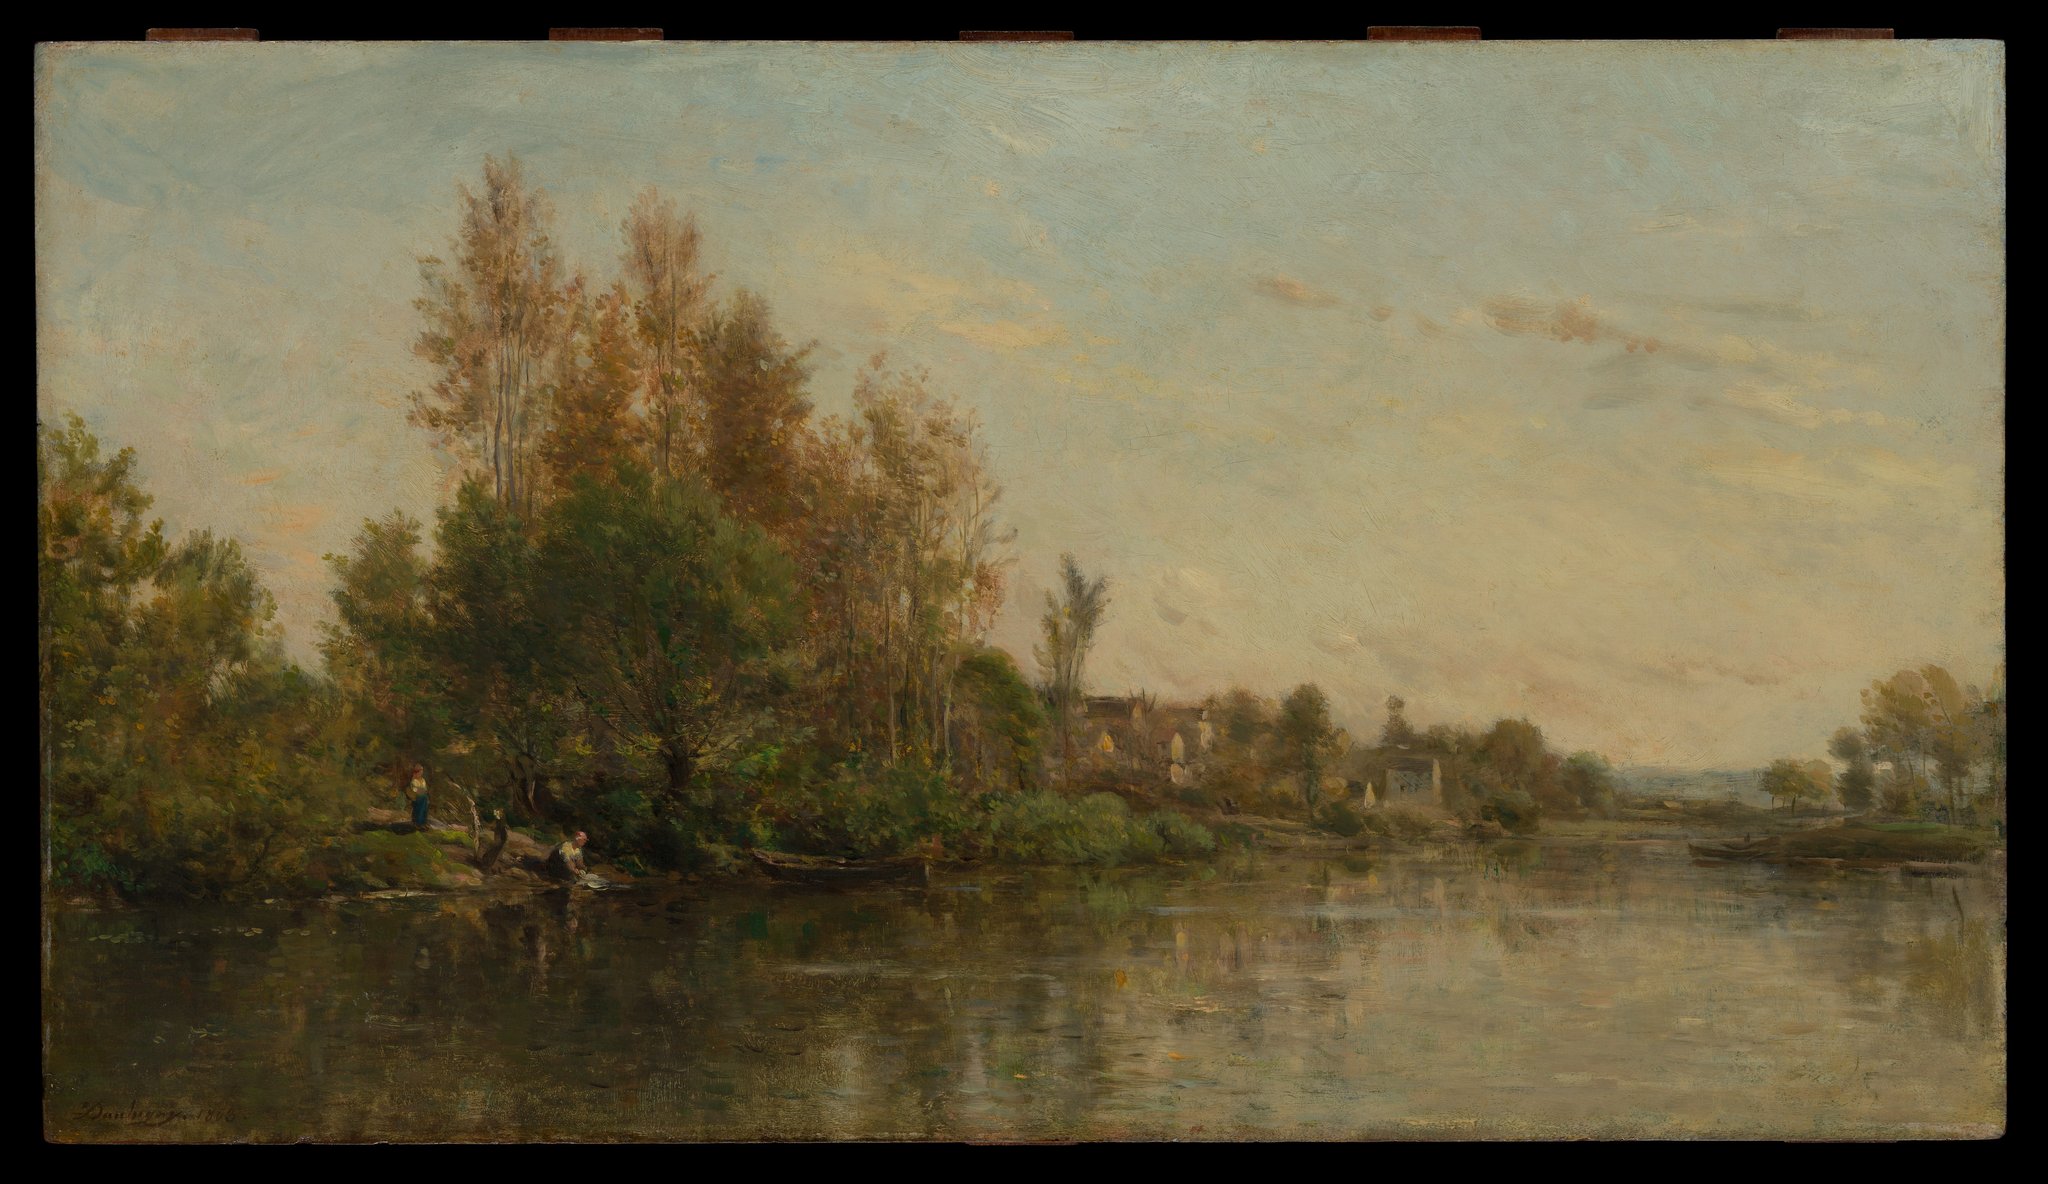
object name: painting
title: The Banks of the Oise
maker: charles-françois daubigny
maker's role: artist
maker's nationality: french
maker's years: 1817-1878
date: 1863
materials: oil, wood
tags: rivers